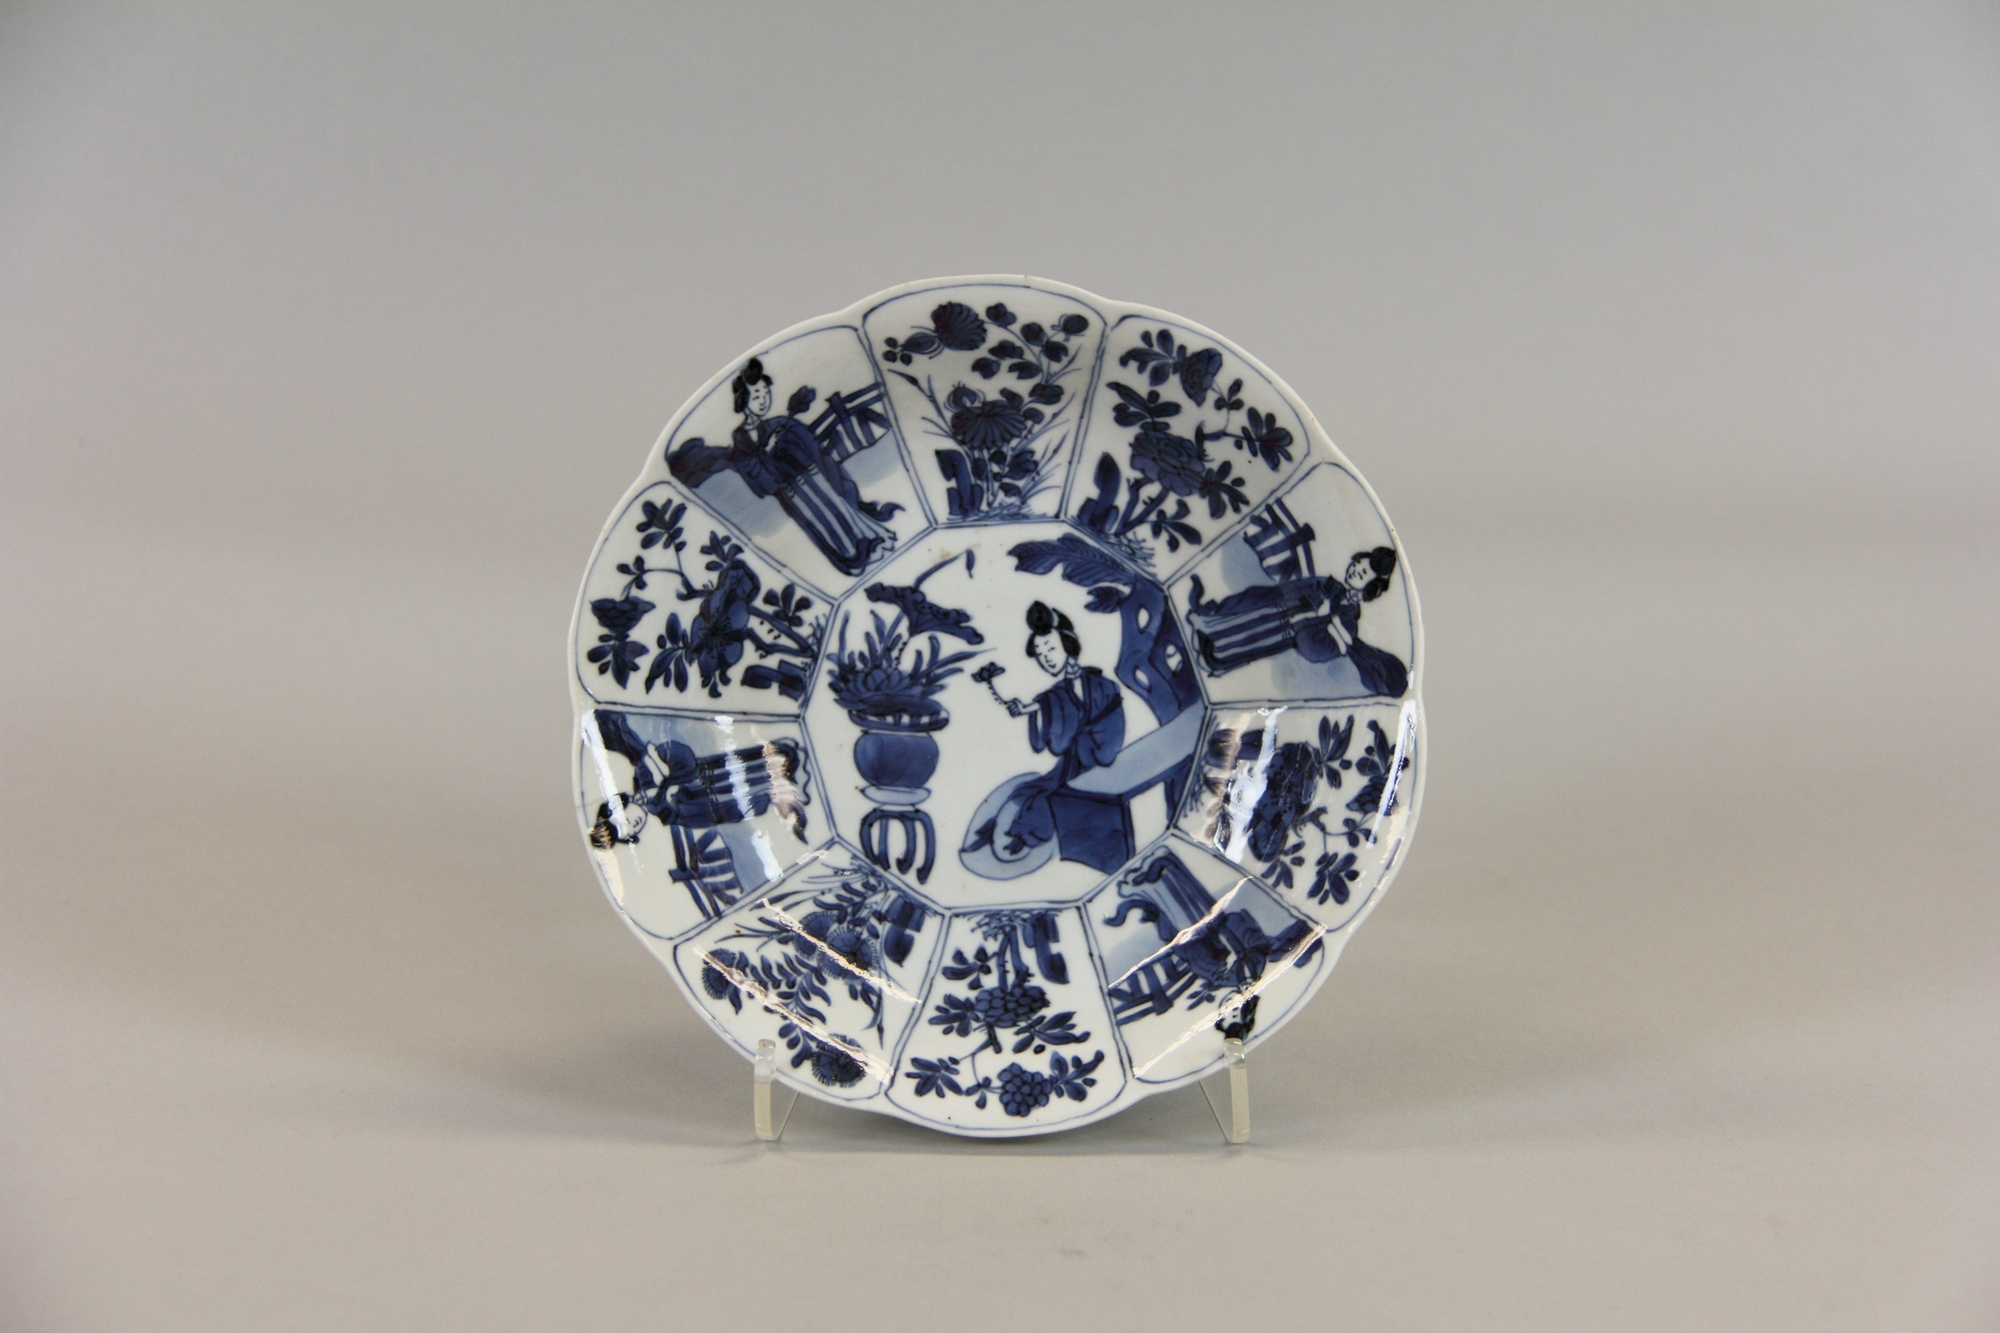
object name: dish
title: Dish with ladies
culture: chinese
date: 1667-1733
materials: cobalt, porcelain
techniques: painting, underglaze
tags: women